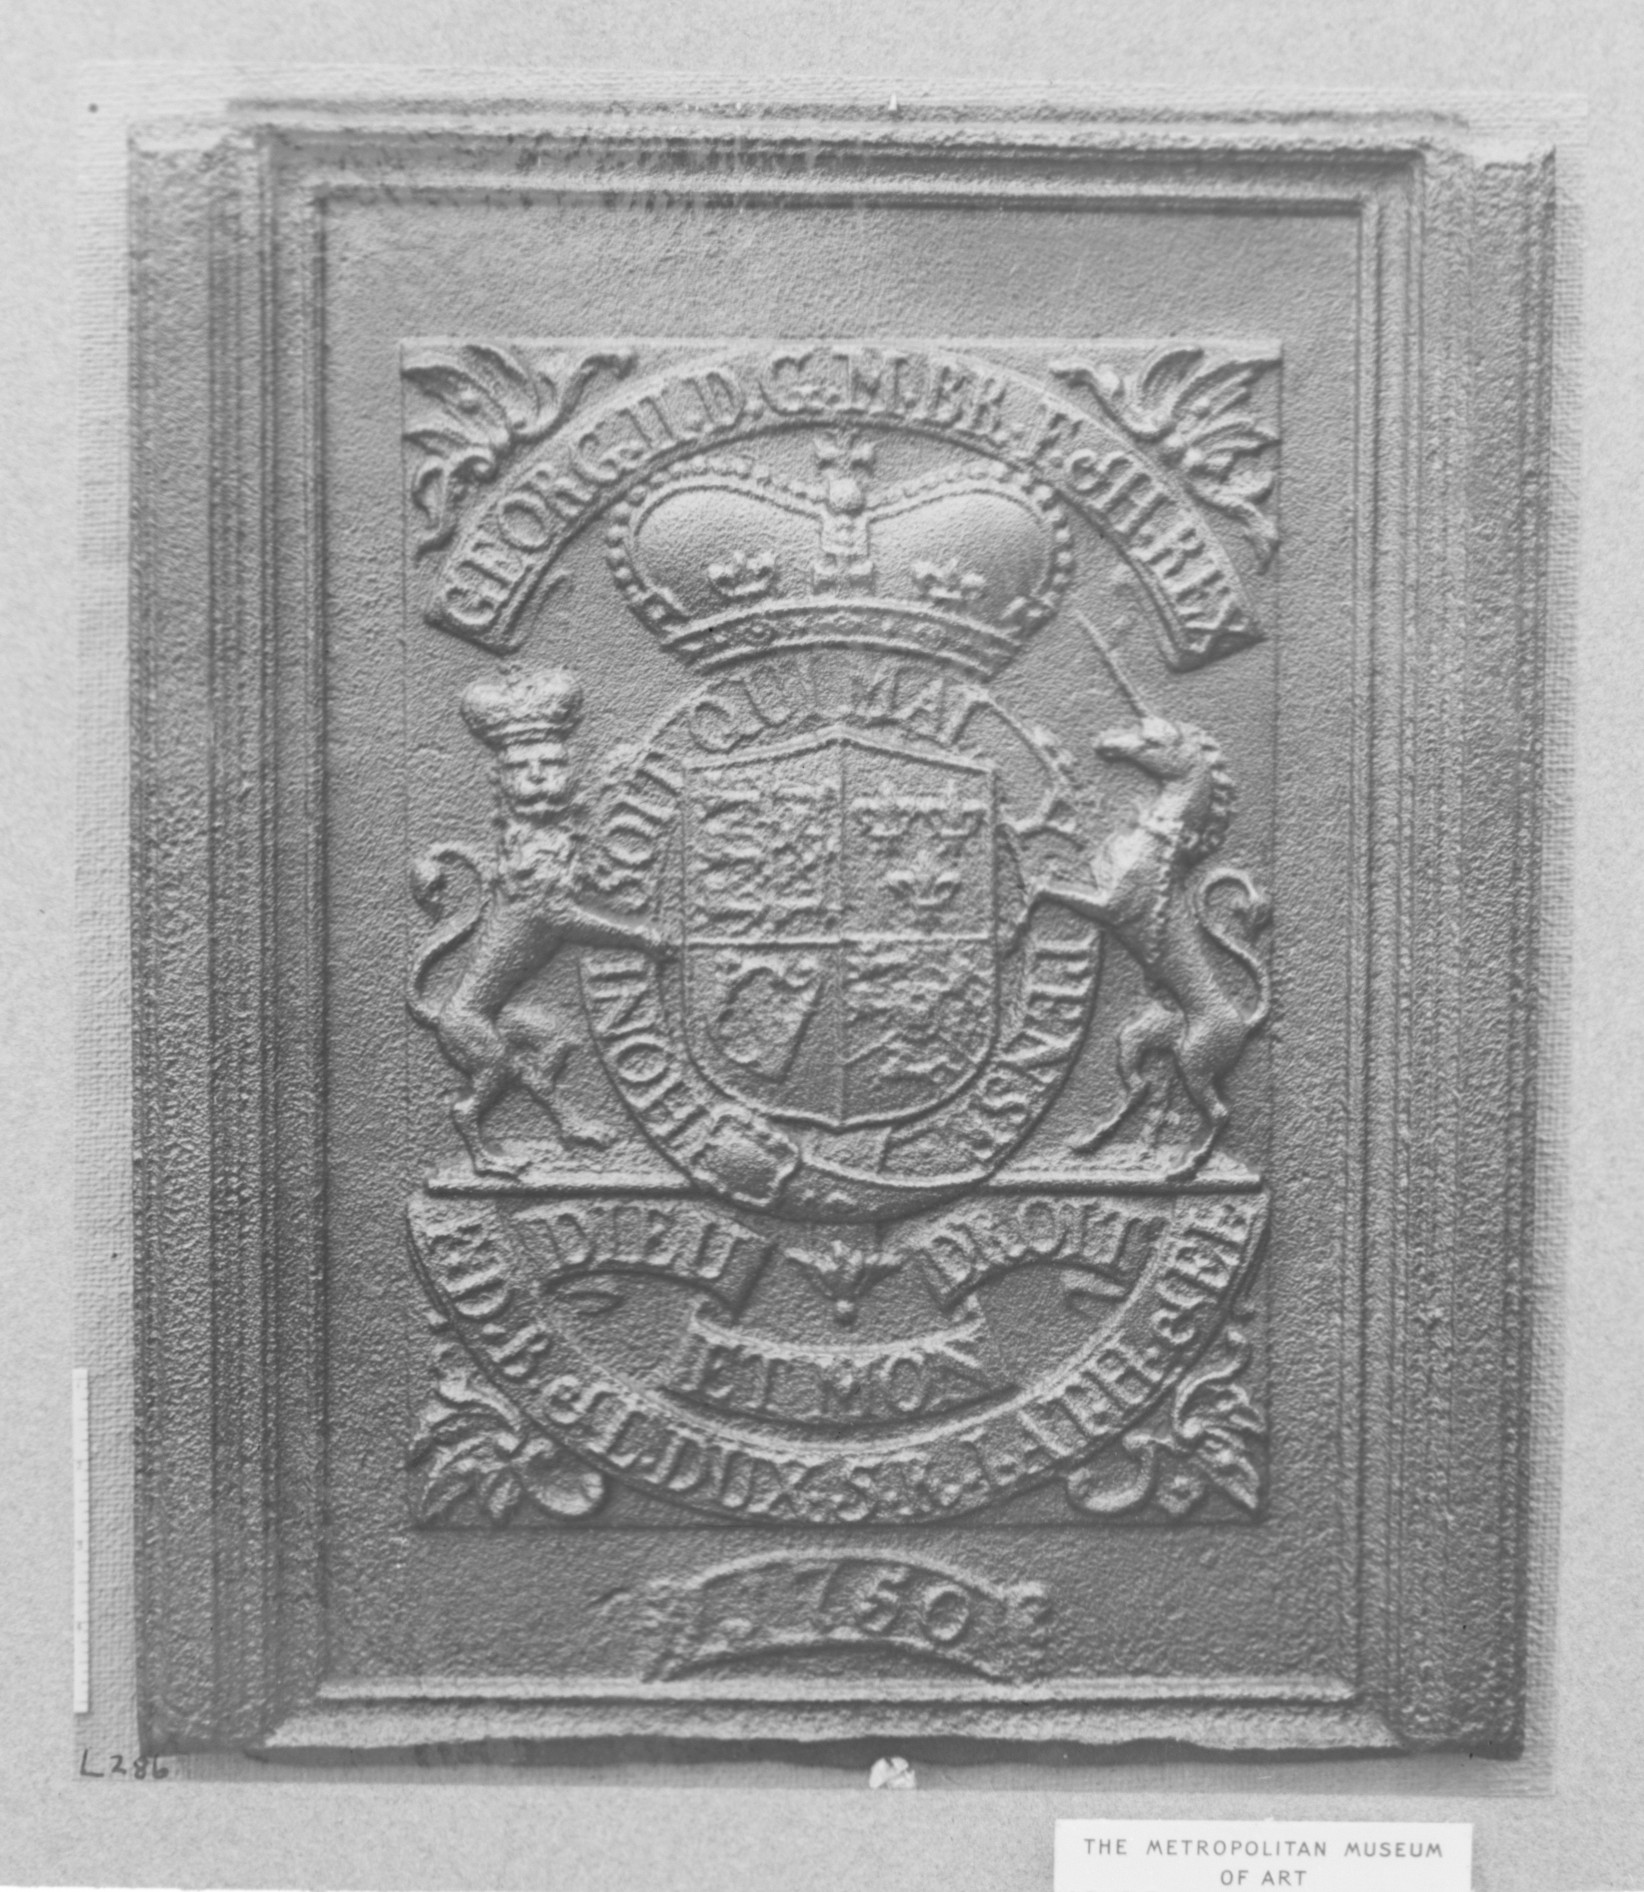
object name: stove plate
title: Stove plate with the royal arms of George II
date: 1750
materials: iron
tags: coat of arms